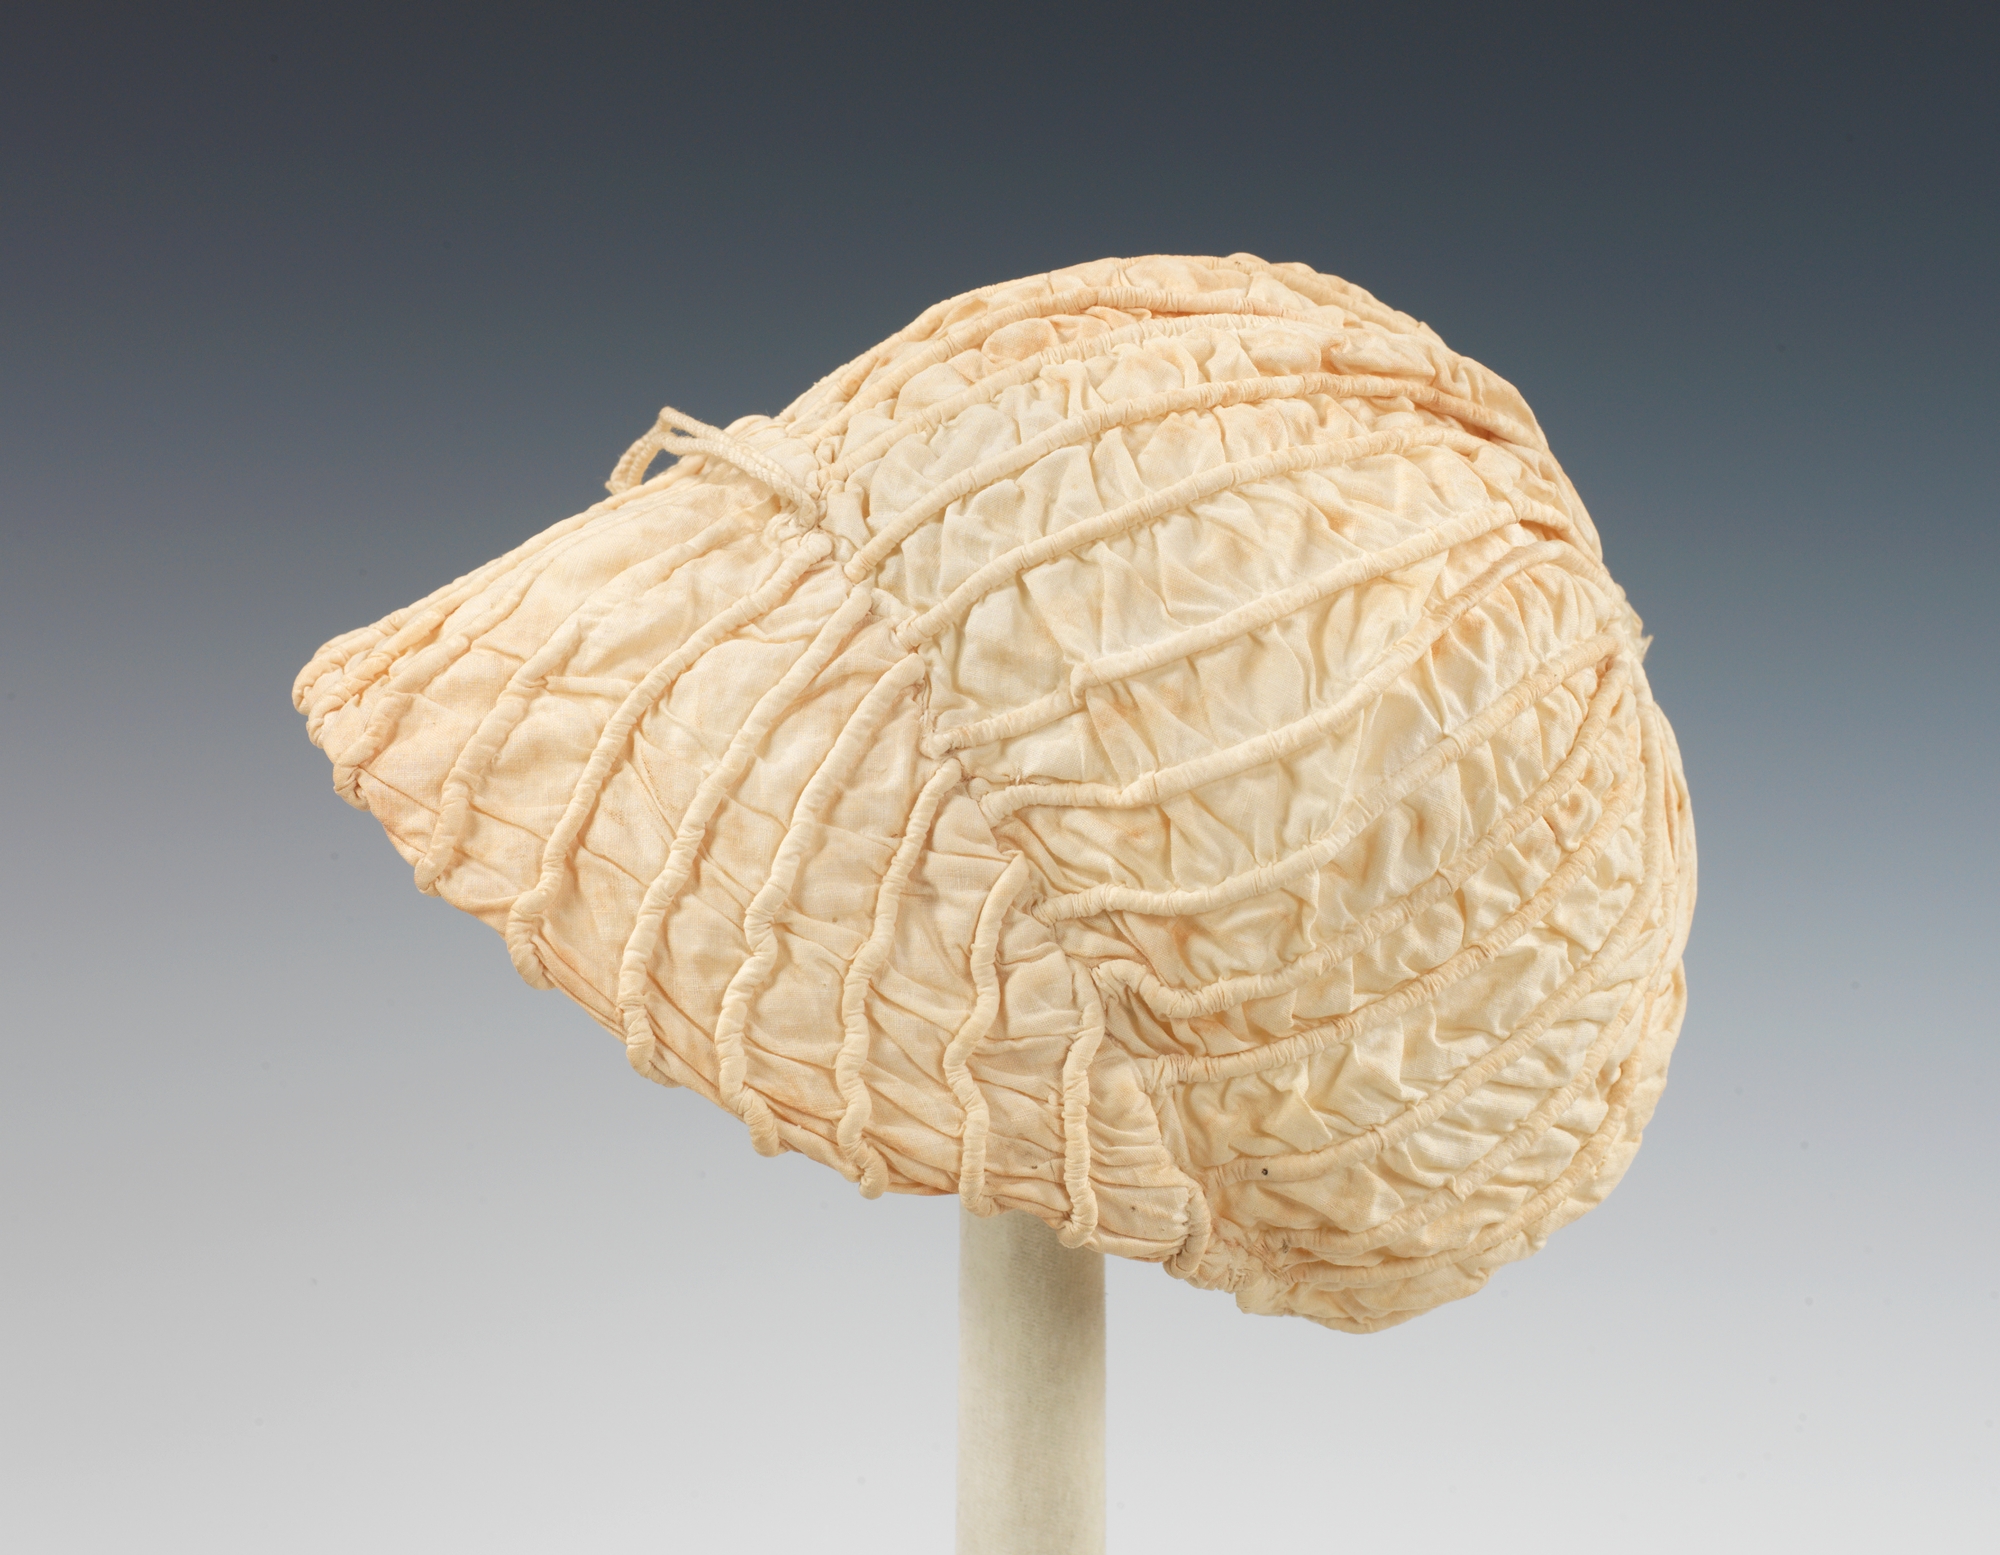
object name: cap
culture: american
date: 1820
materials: cotton